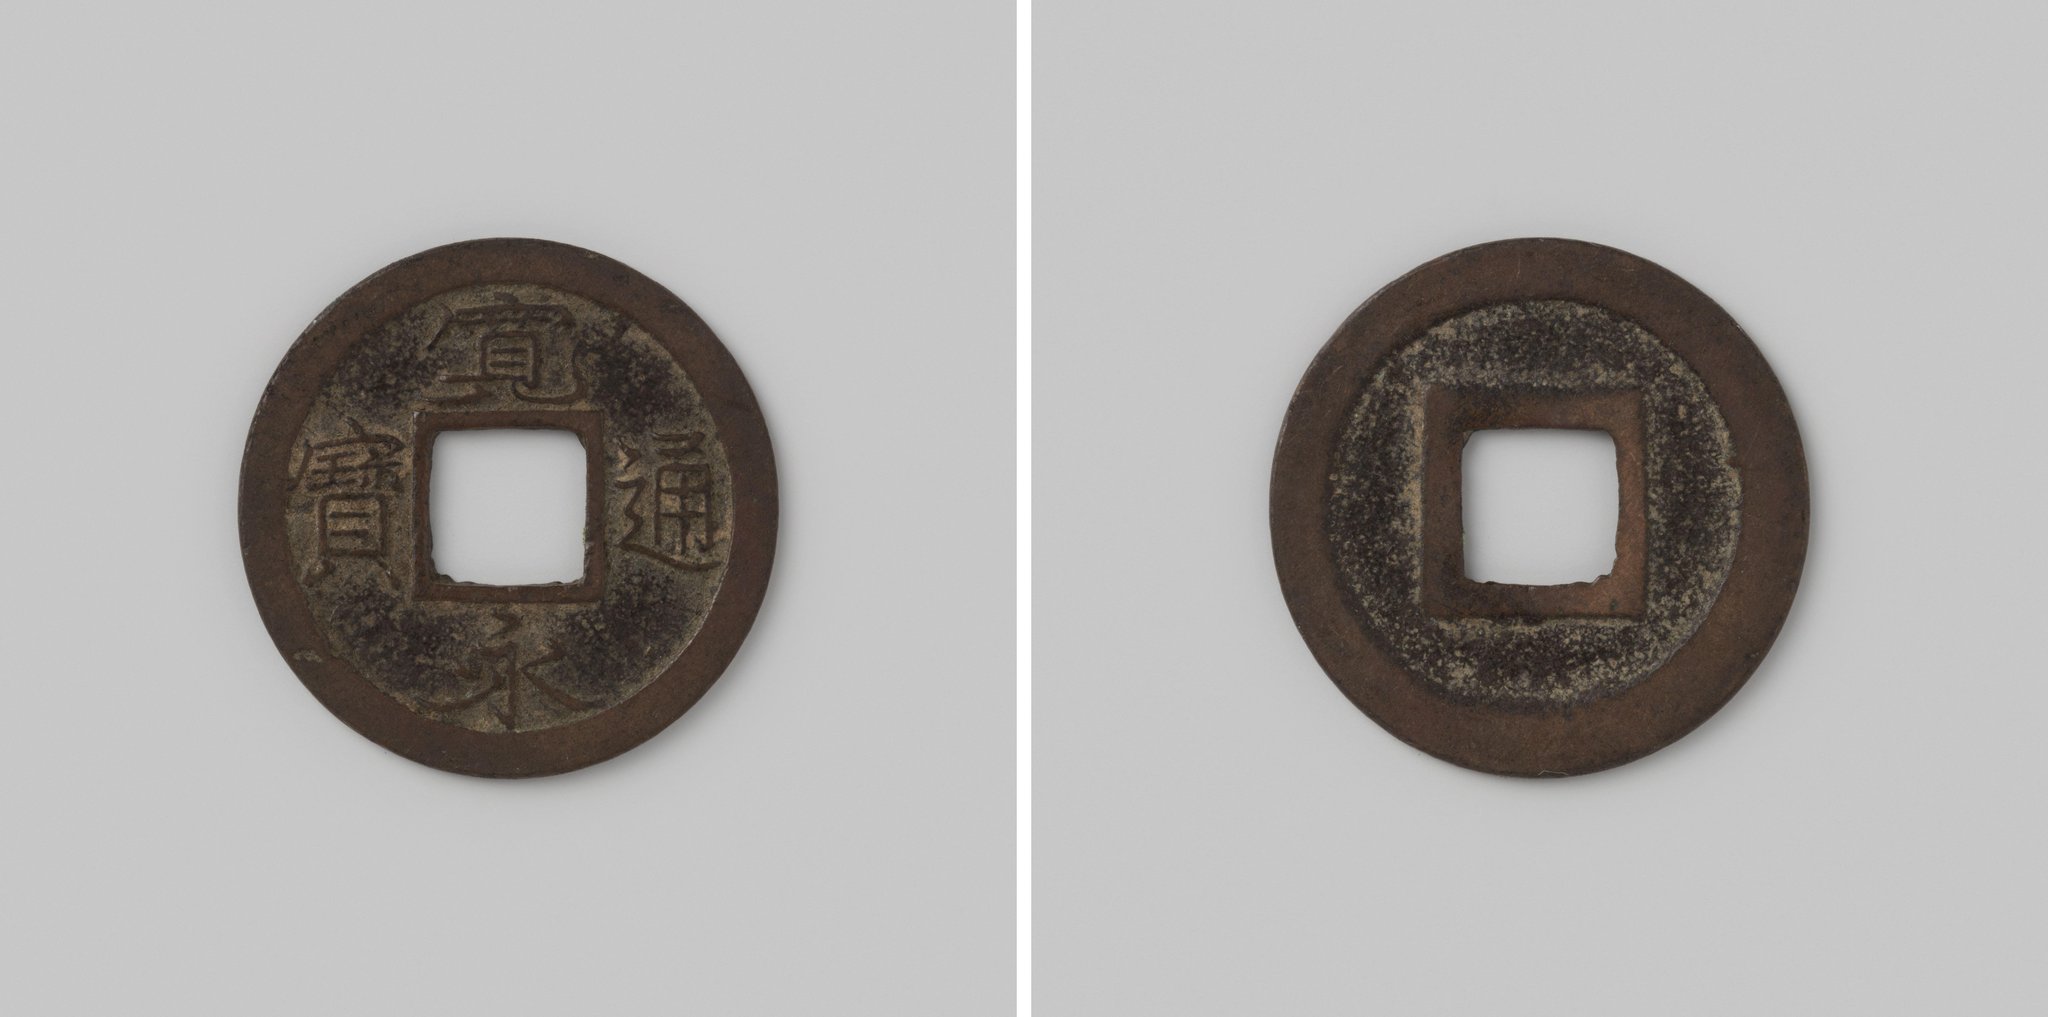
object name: mon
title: Bun sen van 1 mon uit het keizerrijk Japan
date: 1662-1672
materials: copper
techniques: casting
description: Koperen munt. Voorzijde: binnen brede gladde rand rondom vierkante uitsparing in het midden vier kruisgewijze geplaatste tekens met de betekenis: kanei tsuho [= kanei periode]. Keerzijde: binnen brede gladde rand bovenaan letterteken. [ bun = gegoten van het Boeddha-beeld dat in 1662 bij een aardbeving gedeeltelijk werd vernietigd].